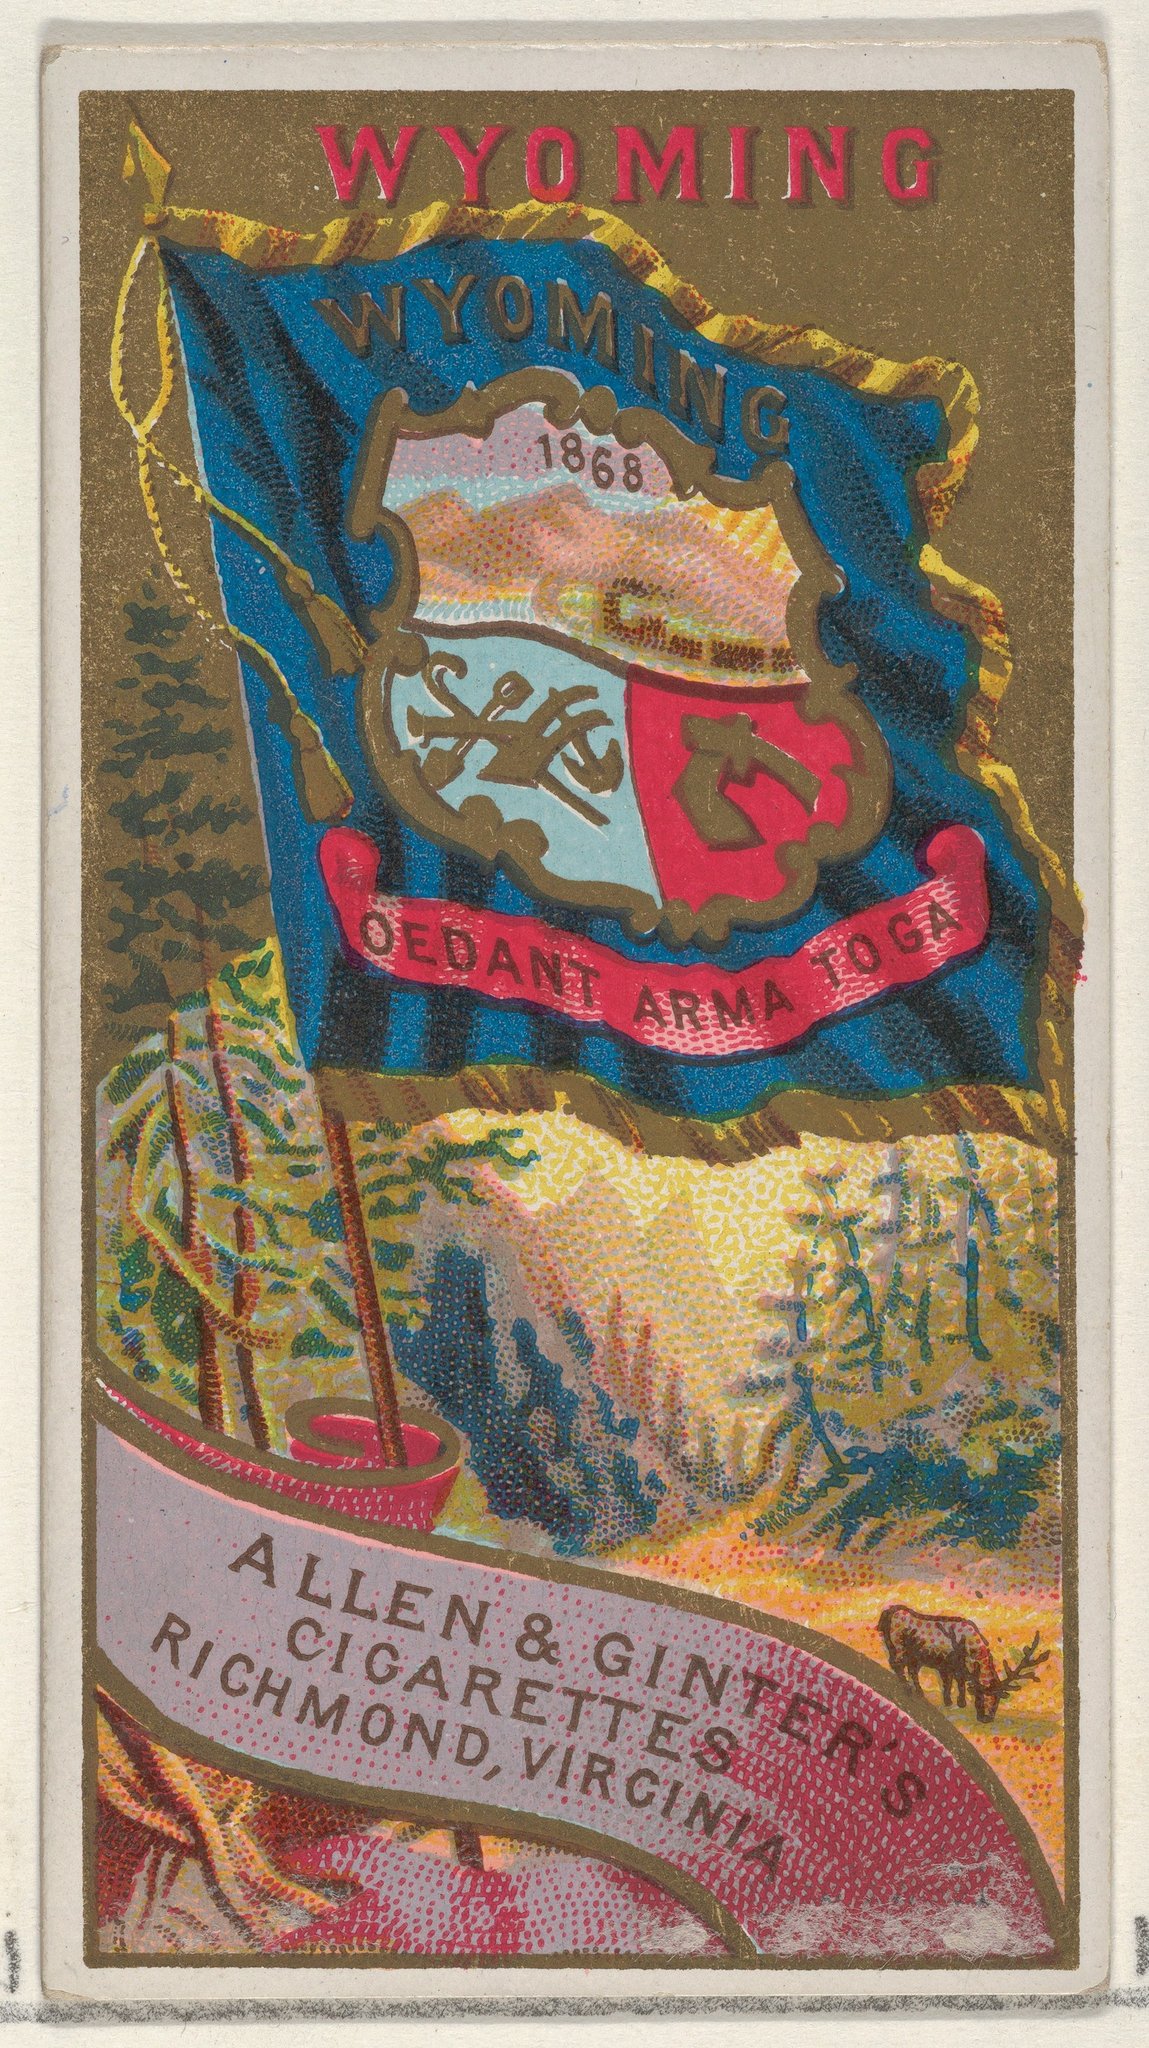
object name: print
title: Wyoming, from Flags of the States and Territories (N11) for Allen & Ginter Cigarettes Brands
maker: allen & ginter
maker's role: publisher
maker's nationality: american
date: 1888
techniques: color lithograph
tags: coat of arms,flags